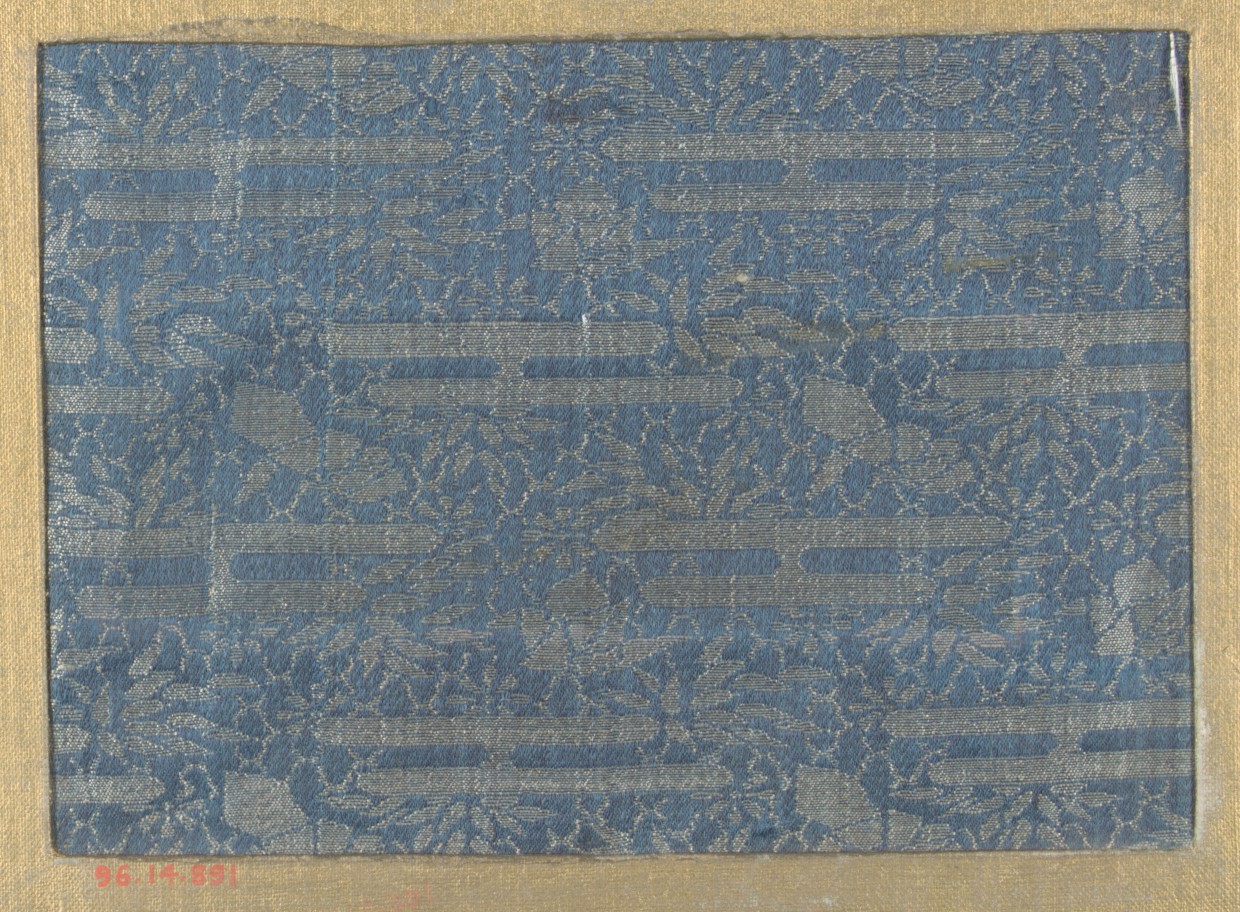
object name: piece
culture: japanese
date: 1701-1900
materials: silk